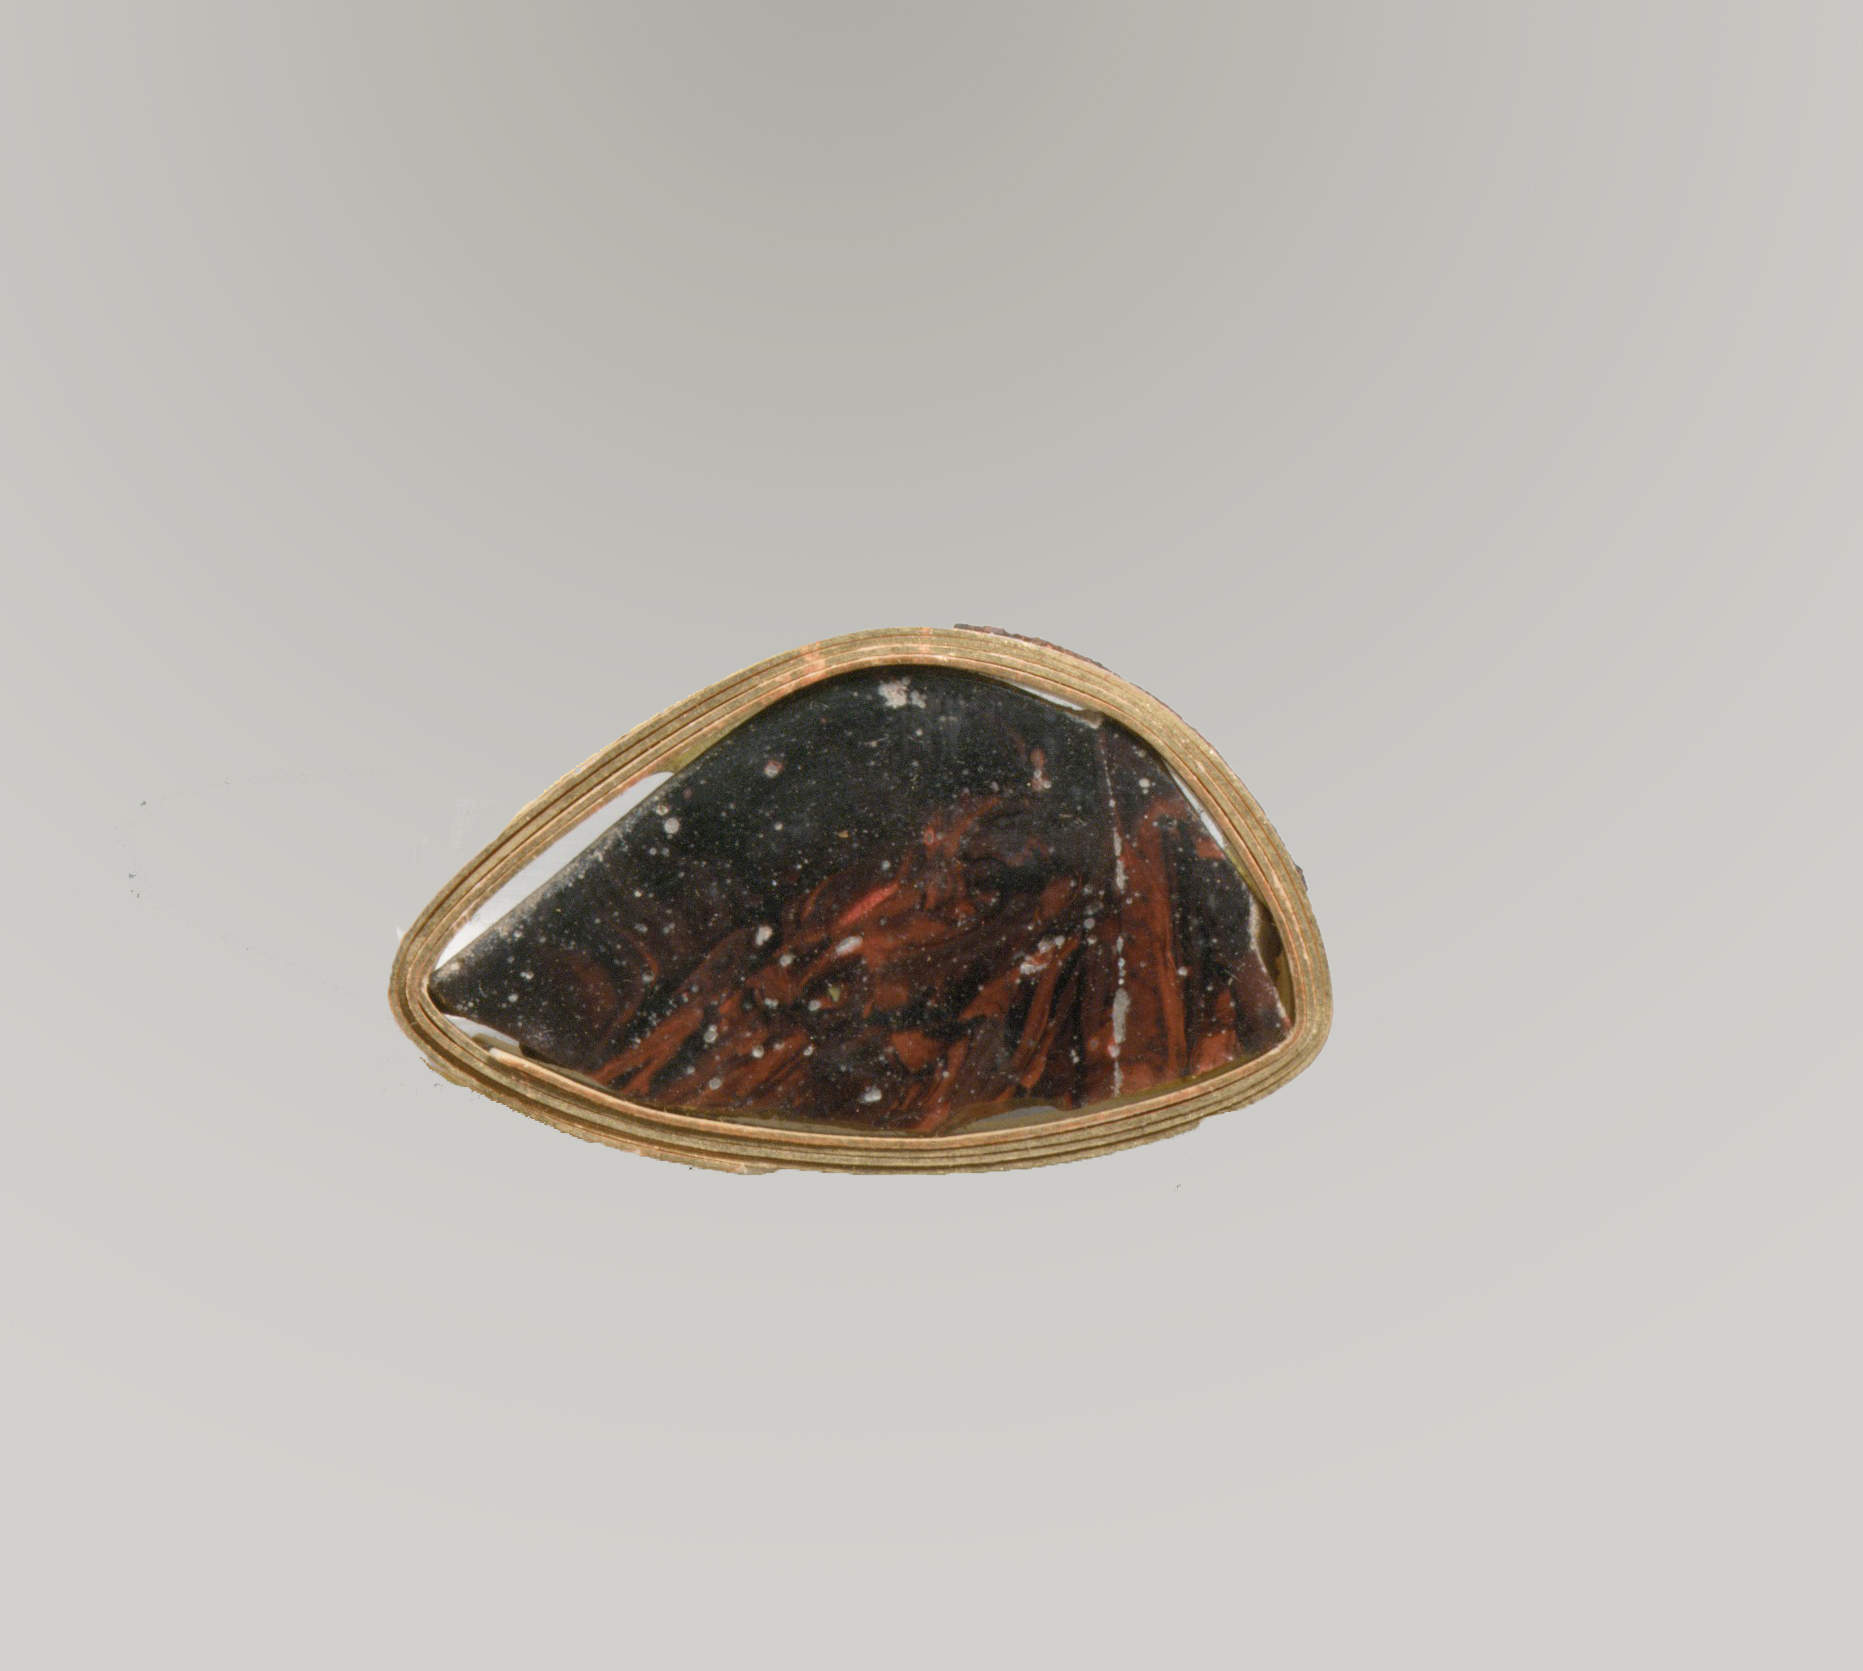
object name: fragment, mosaic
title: Glass mosaic inlay fragment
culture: roman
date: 34 BCE-33 CE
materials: glass